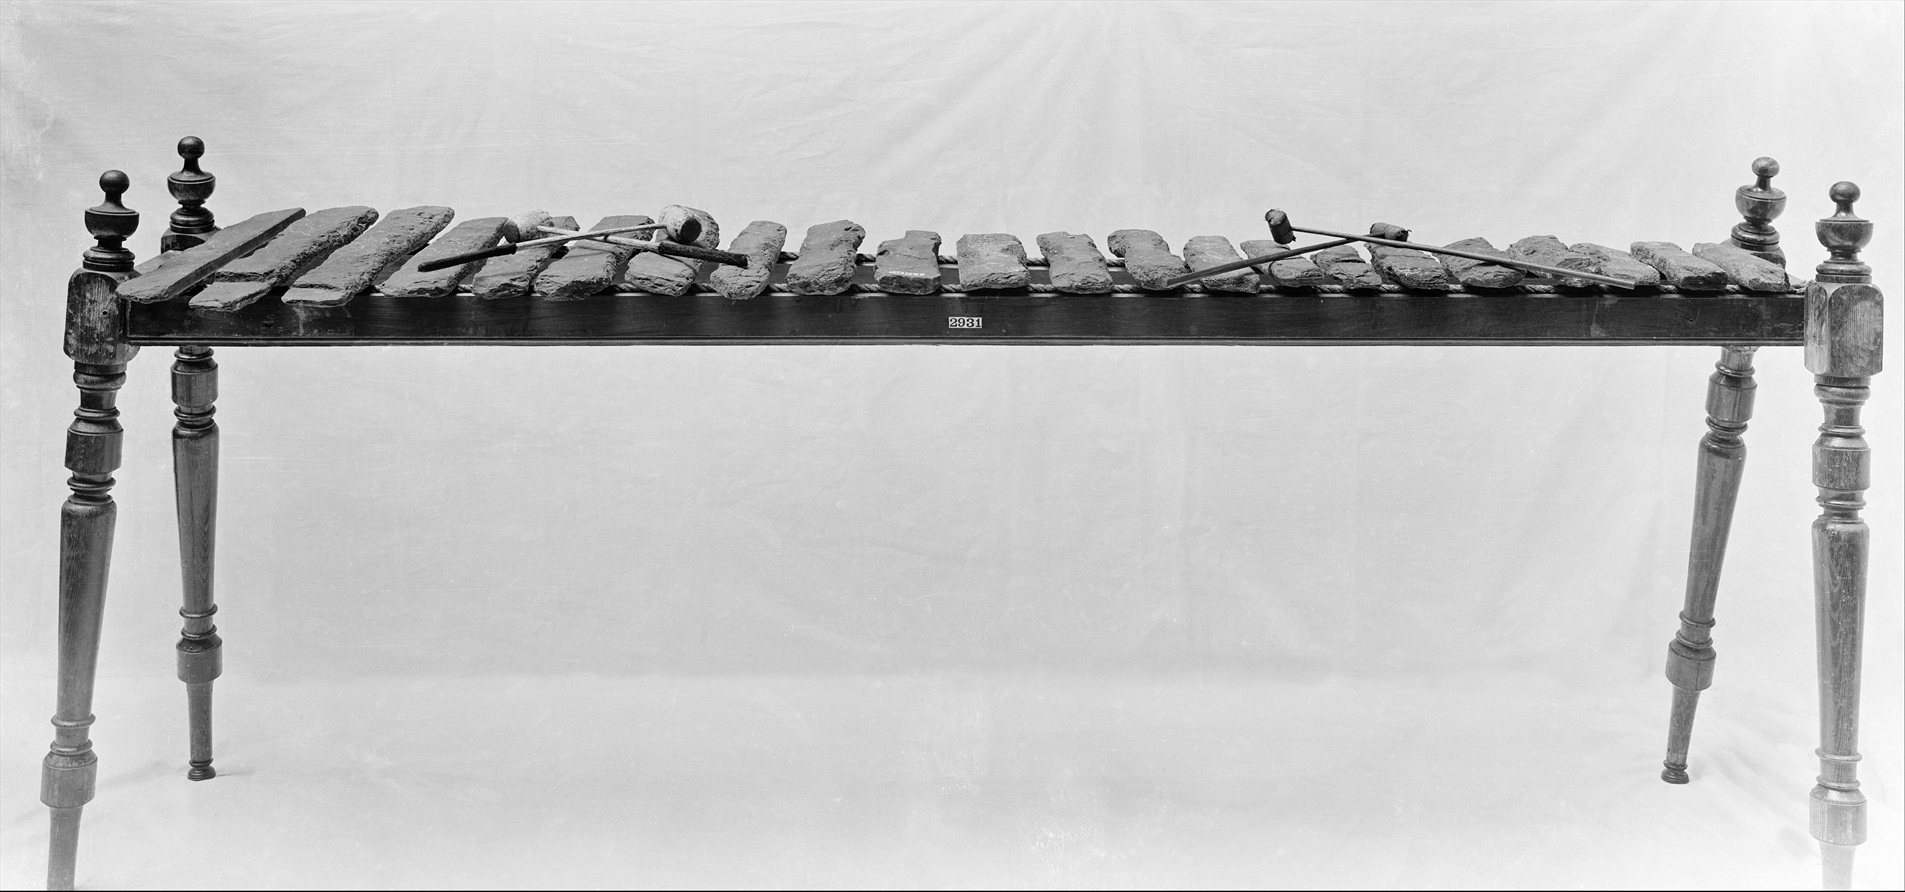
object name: rock harmonicon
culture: british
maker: william till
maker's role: maker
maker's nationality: british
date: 1880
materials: stone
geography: united kingdom